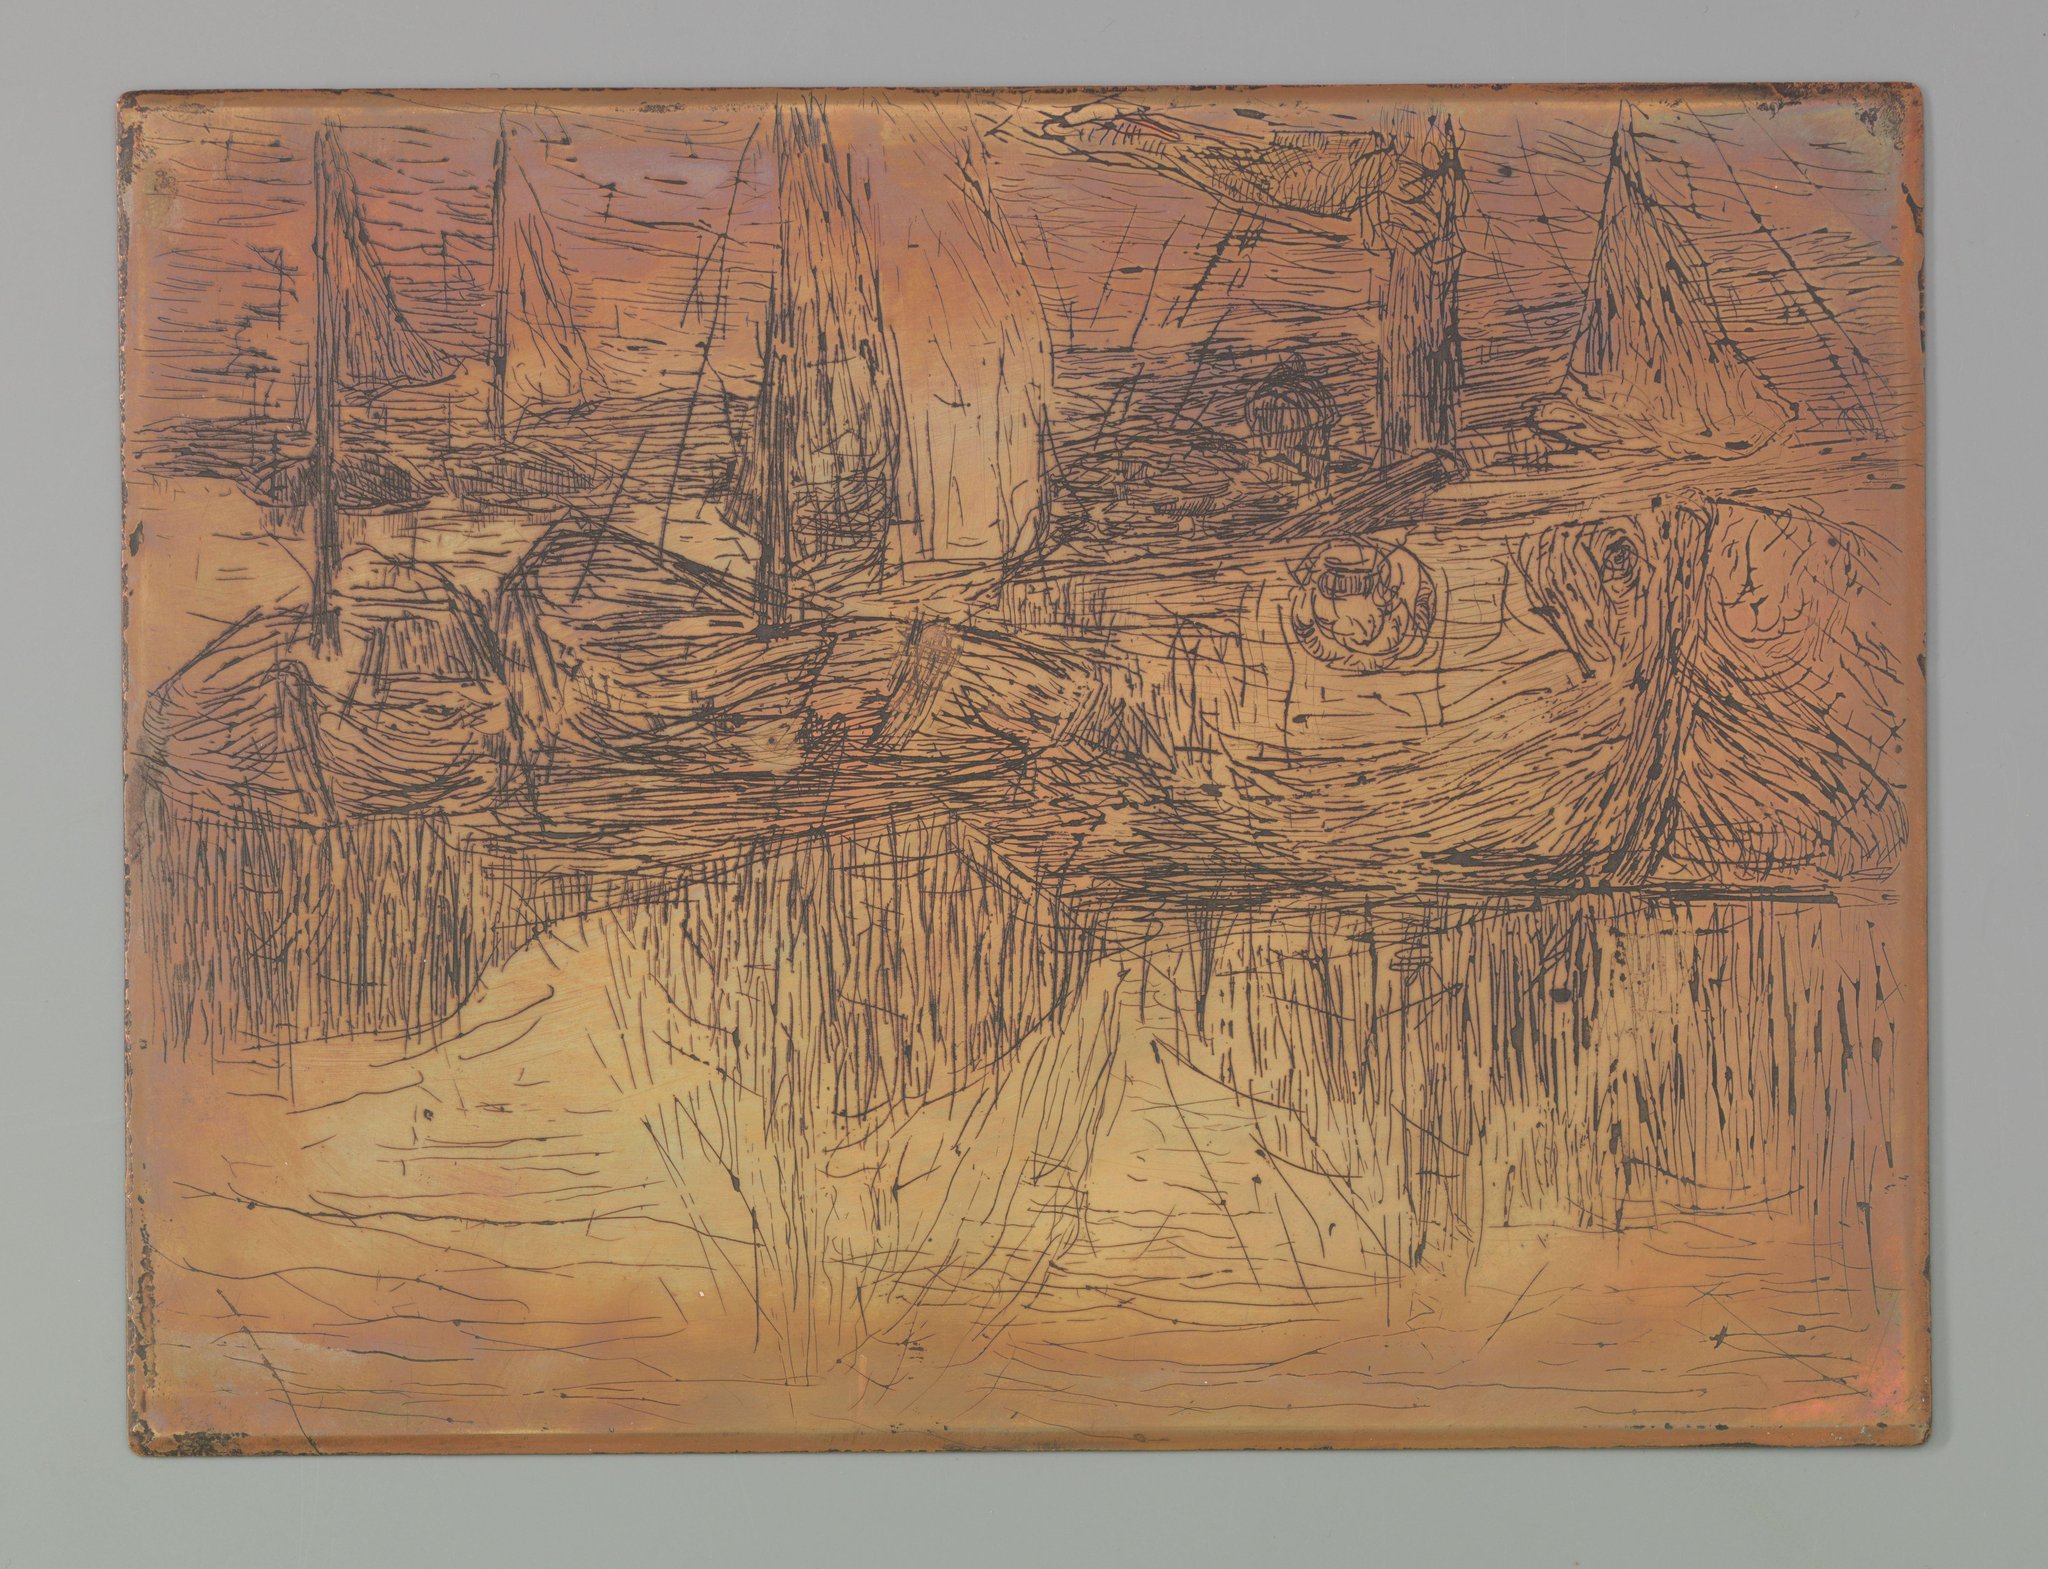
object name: copper plate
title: Schepen in haven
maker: floris verster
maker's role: draughtsman, painter, print maker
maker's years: 1861-1927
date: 1890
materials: copper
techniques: etching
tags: harbour